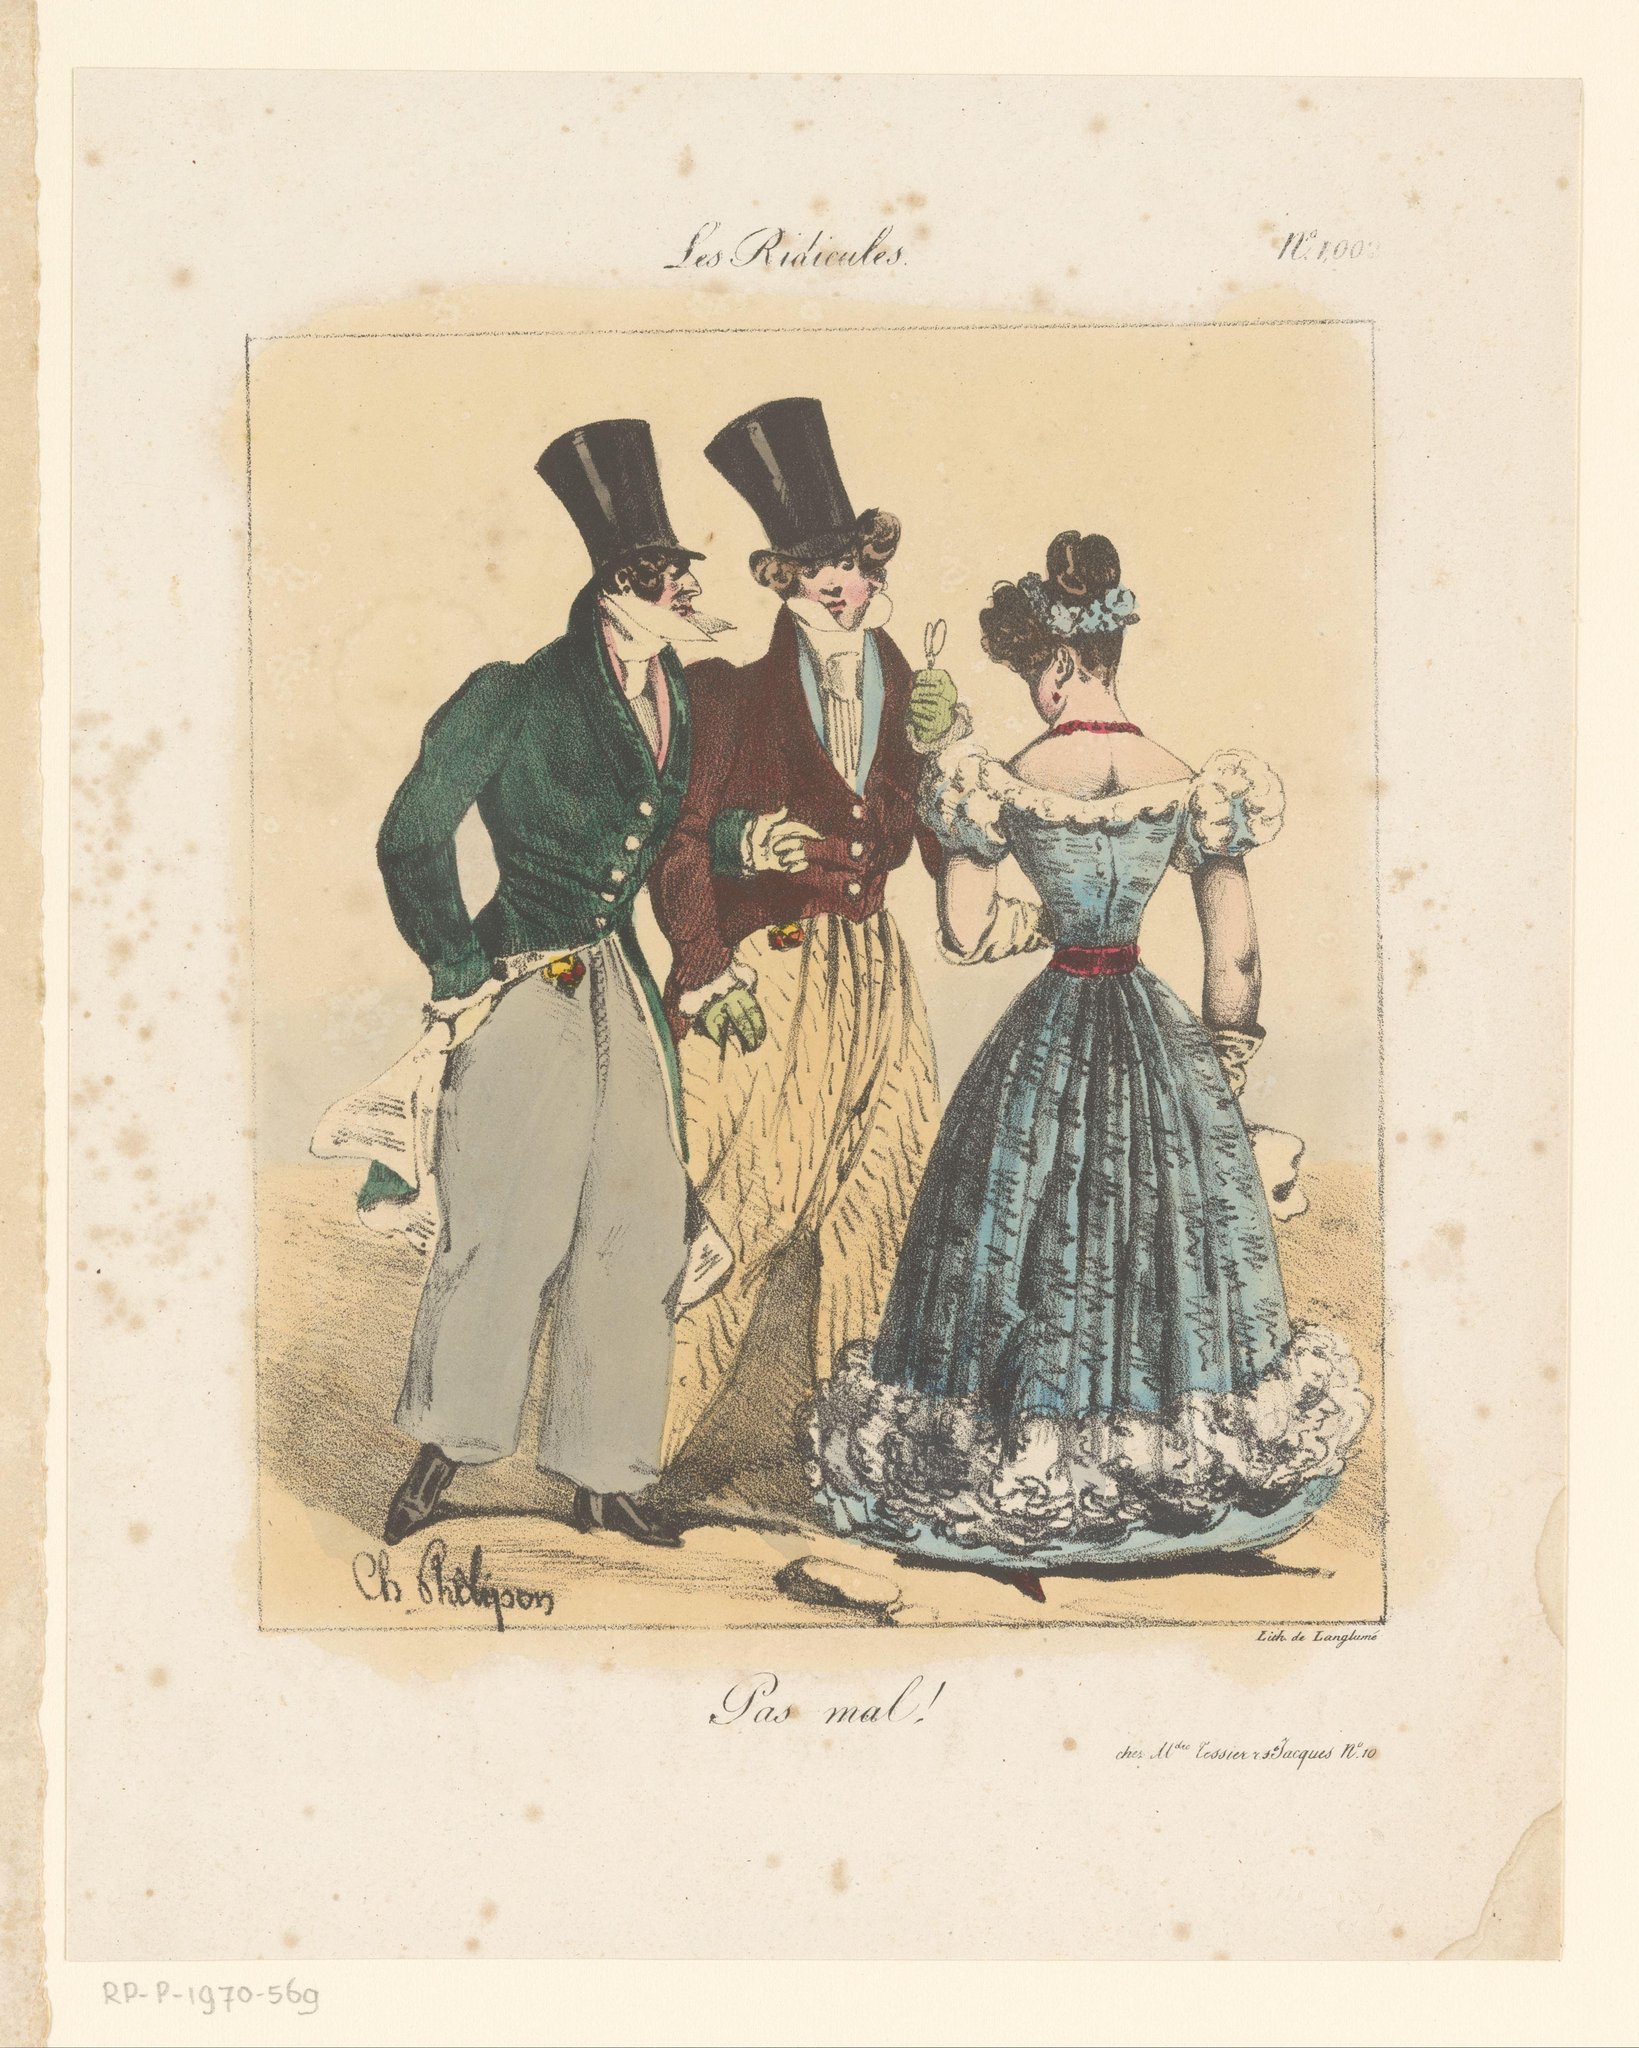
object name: print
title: Vrouw bekijkt twee mannen aandachtig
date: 1818-1830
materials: paper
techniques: hand coloring, lithograph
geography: paris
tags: fashion, clothing, adult woman, adult man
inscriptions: collector's mark: Lugt 2228